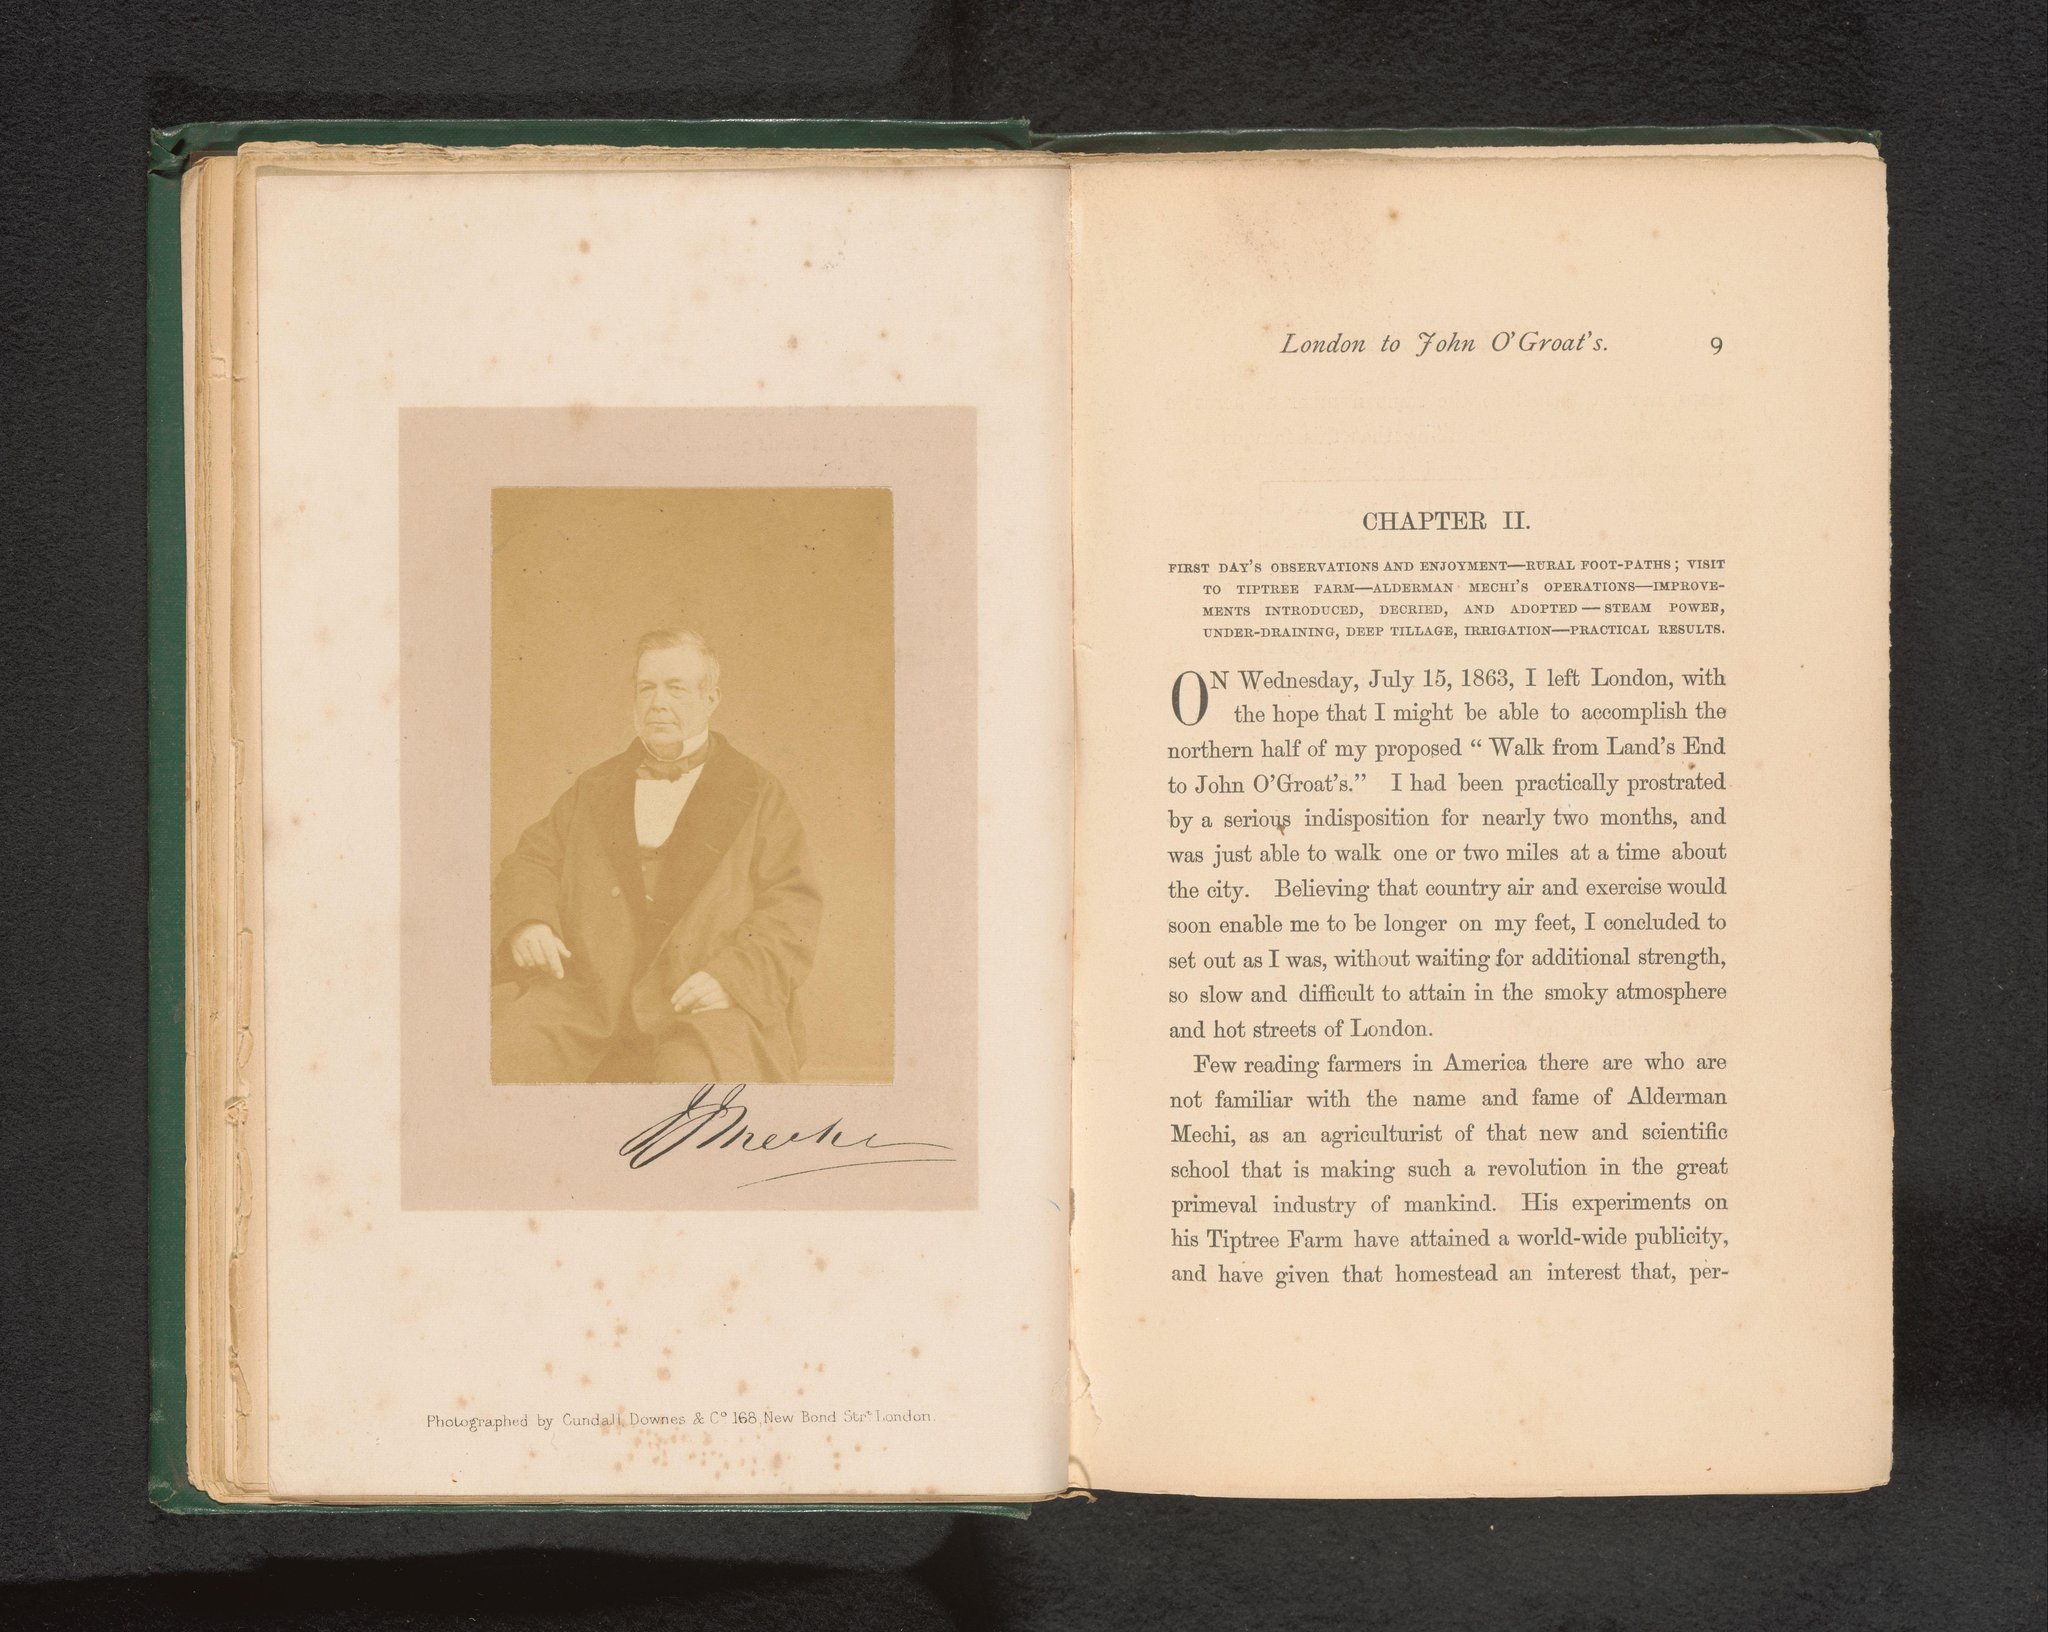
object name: photograph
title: Portret van John Joseph Mechi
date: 1859-1864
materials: photographic support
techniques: albumen print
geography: london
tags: silversmith, smith, blacksmith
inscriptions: inscription: ‘Photographed by Cundall, Downes & Co, 168, New Bond Strt. London’, inscription: ‘JJ Mechi’